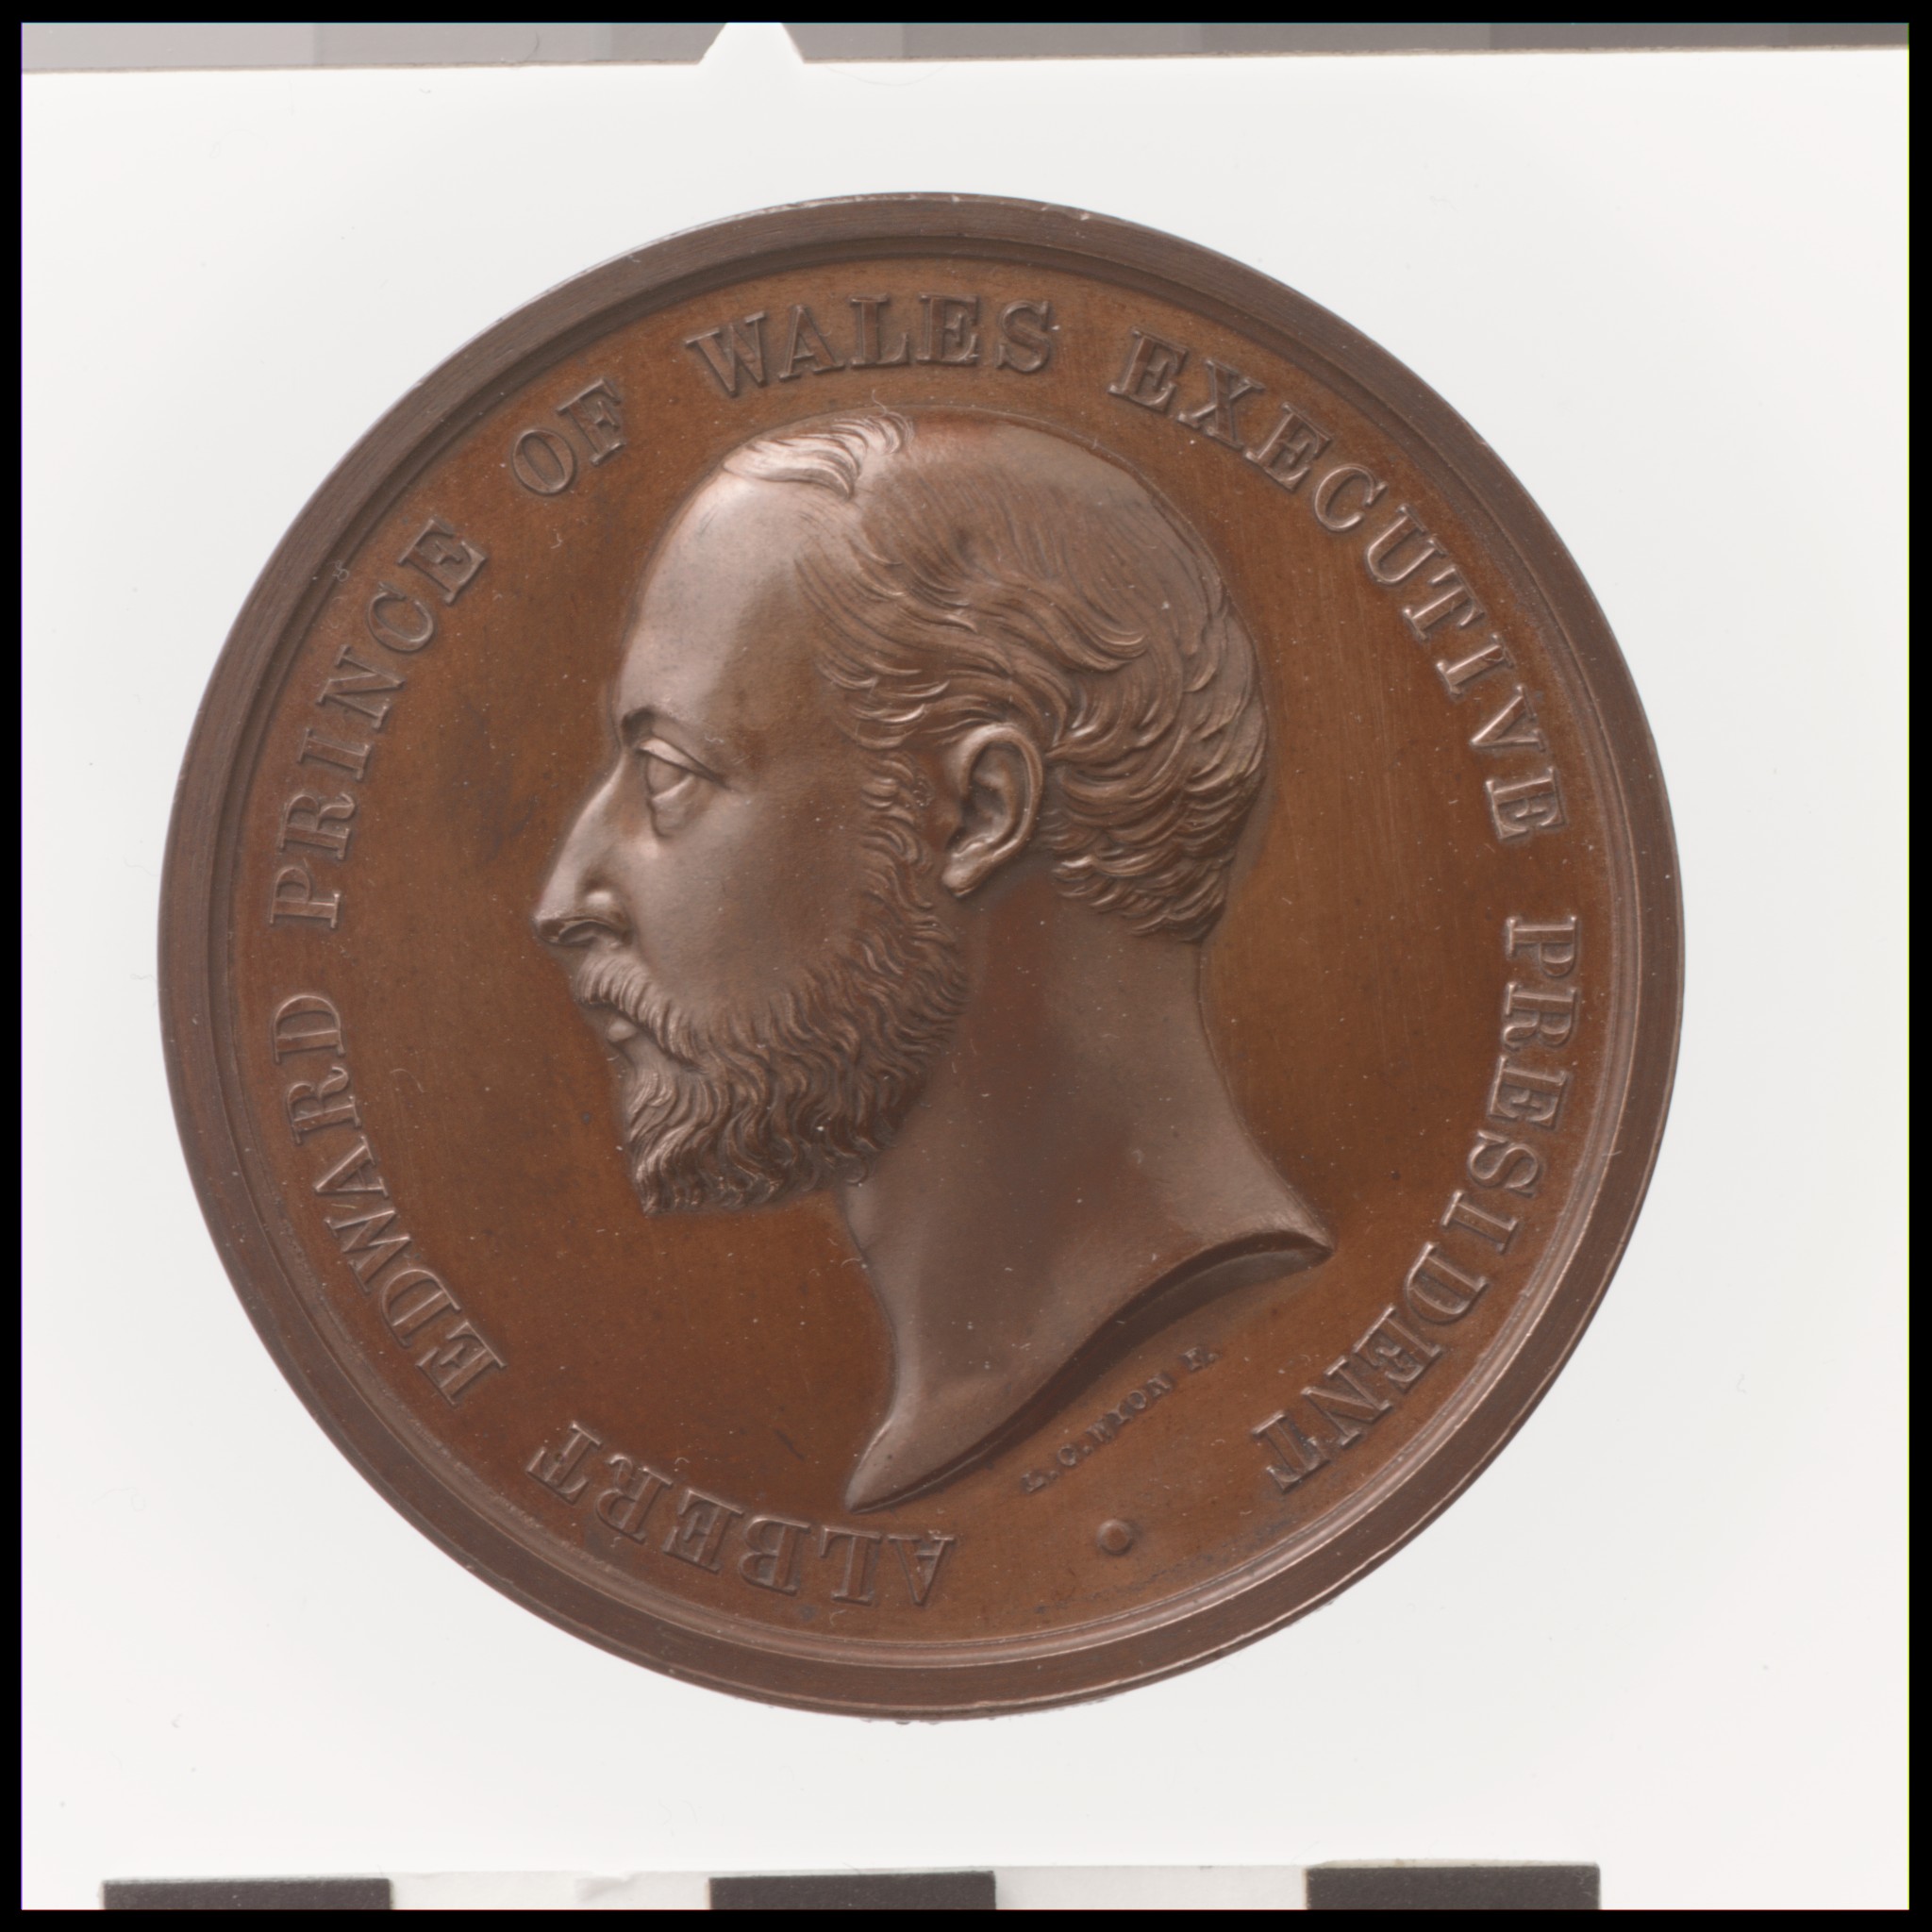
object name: medal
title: Prince of Wales, Colonial and Indian Exhibition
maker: leonard charles wyon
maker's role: artist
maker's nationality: british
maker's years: 1826-1891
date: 1886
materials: bronze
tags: princes,profiles,wreaths